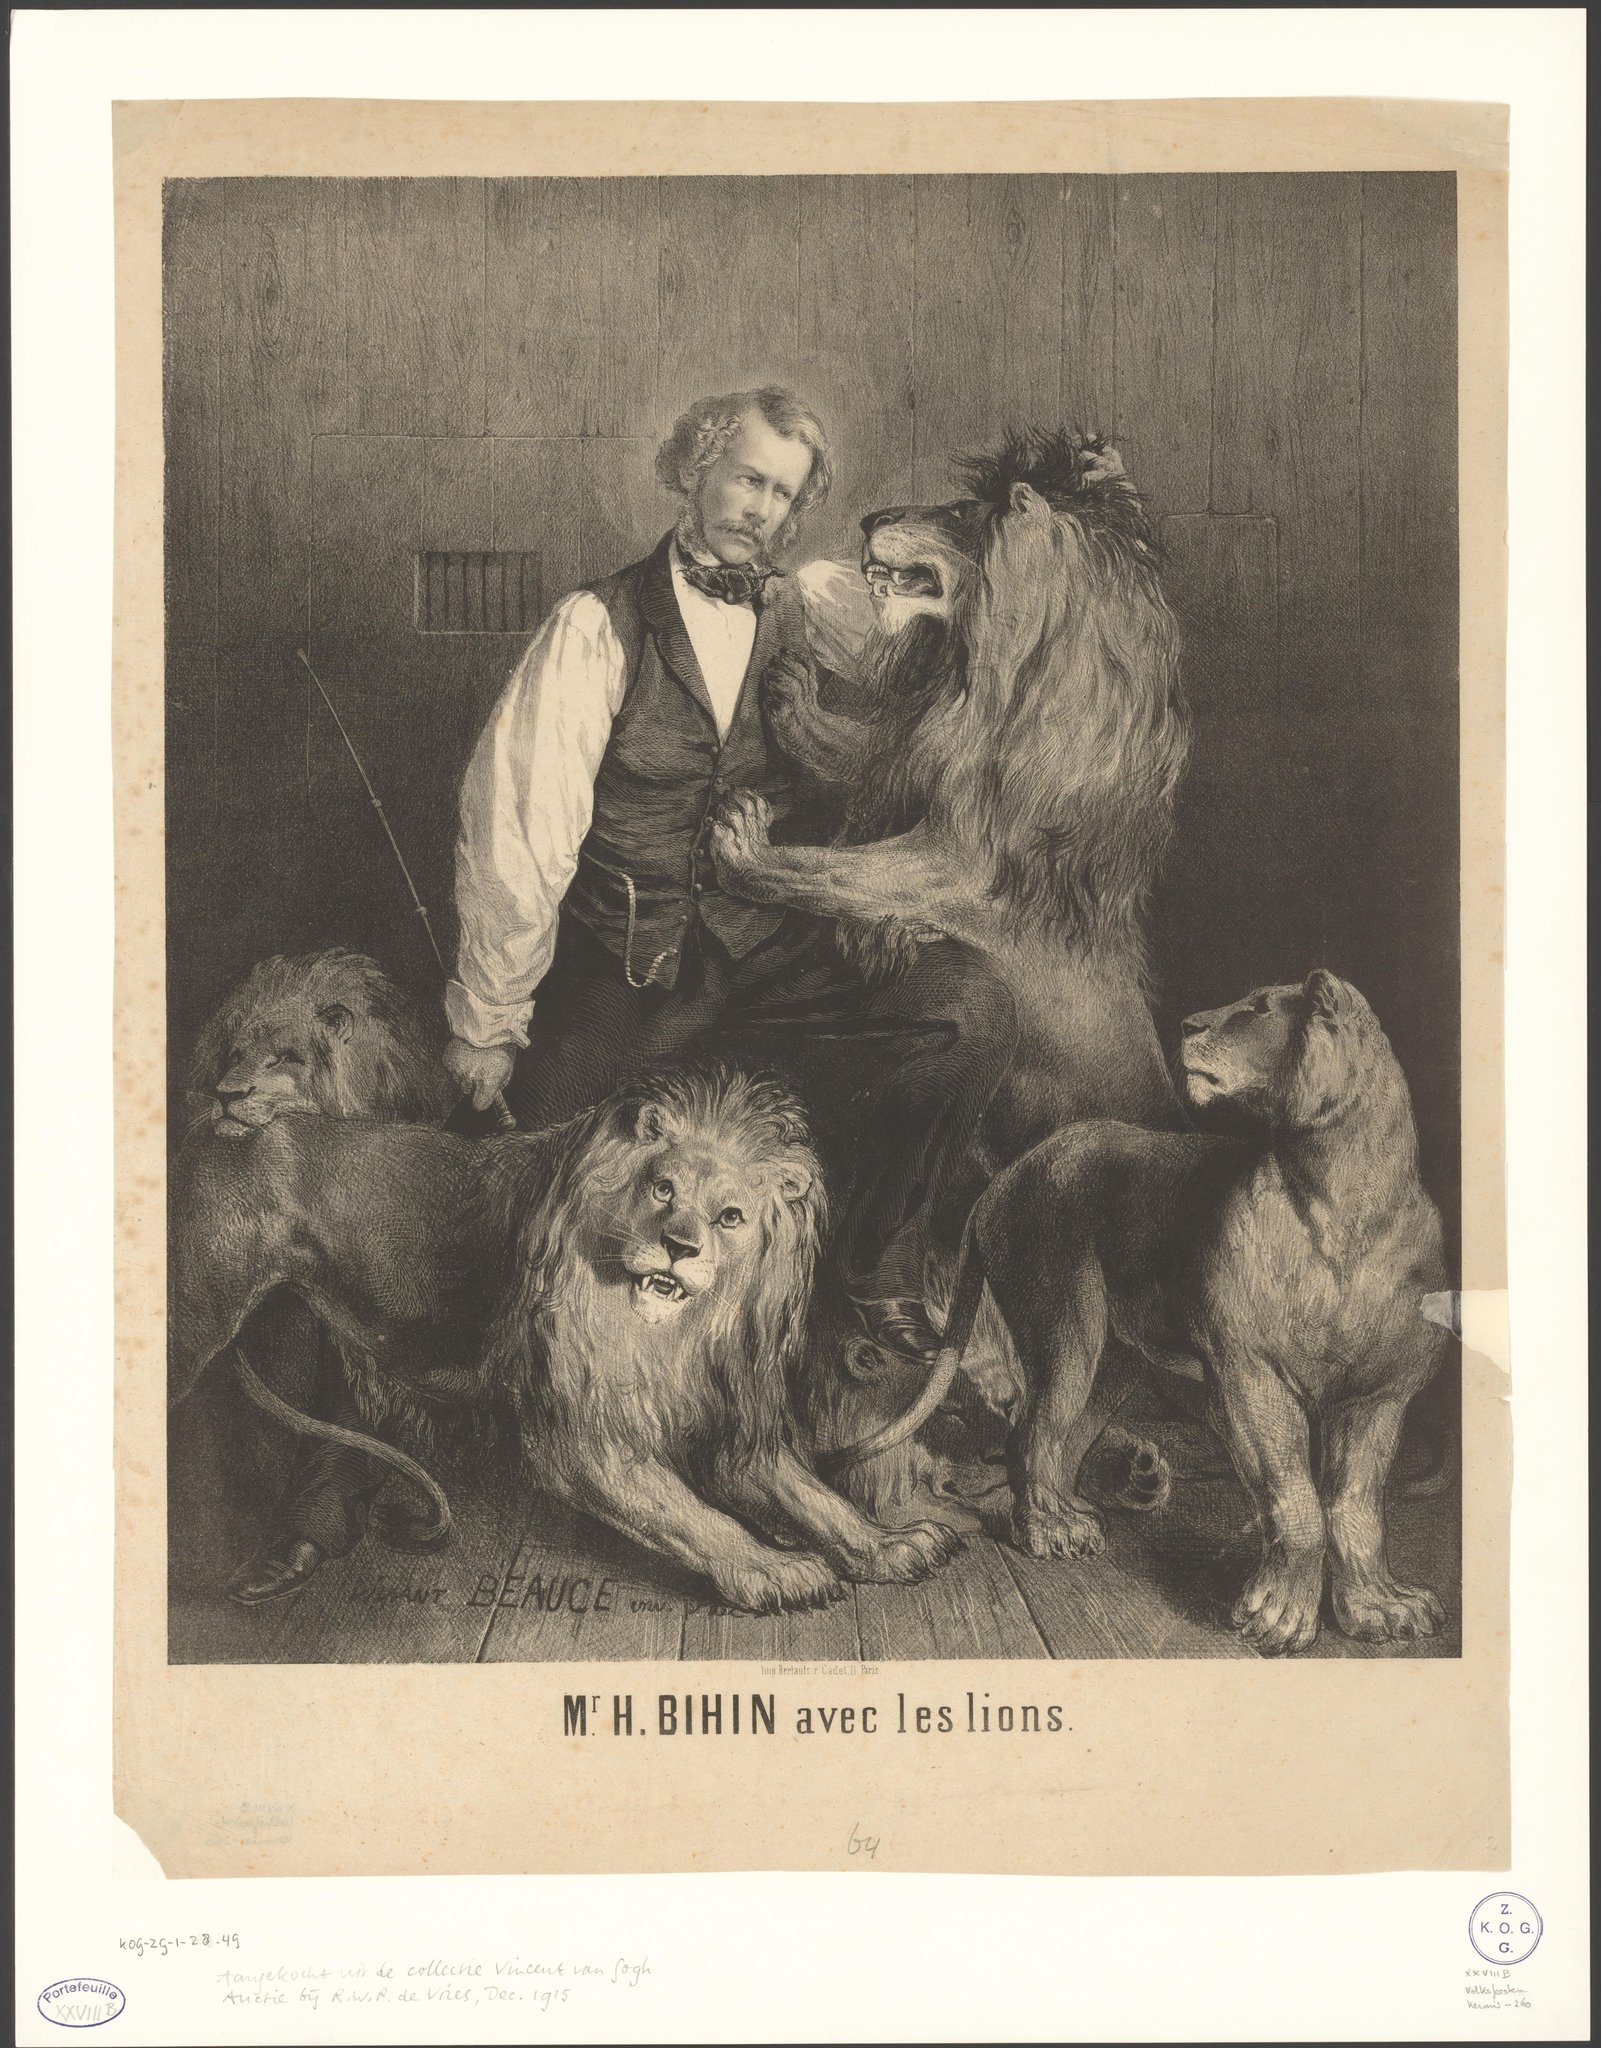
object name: print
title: Leeuwentemmer H. Bihin met vier leeuwen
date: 1851-1865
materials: paper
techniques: lithograph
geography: paris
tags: lions and tigers (circus performance)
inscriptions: collector's mark: Lugt 1641, stamp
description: Onderwerpsrubrieken binnen de Atlas Zeden en Gewoonten: Zeden en Gewoonten in Engeren Zin. Volksleven. Volksfeesten. Circusmenschen, dierentemmers, acrobaten, goochelaars, en dergelijken.